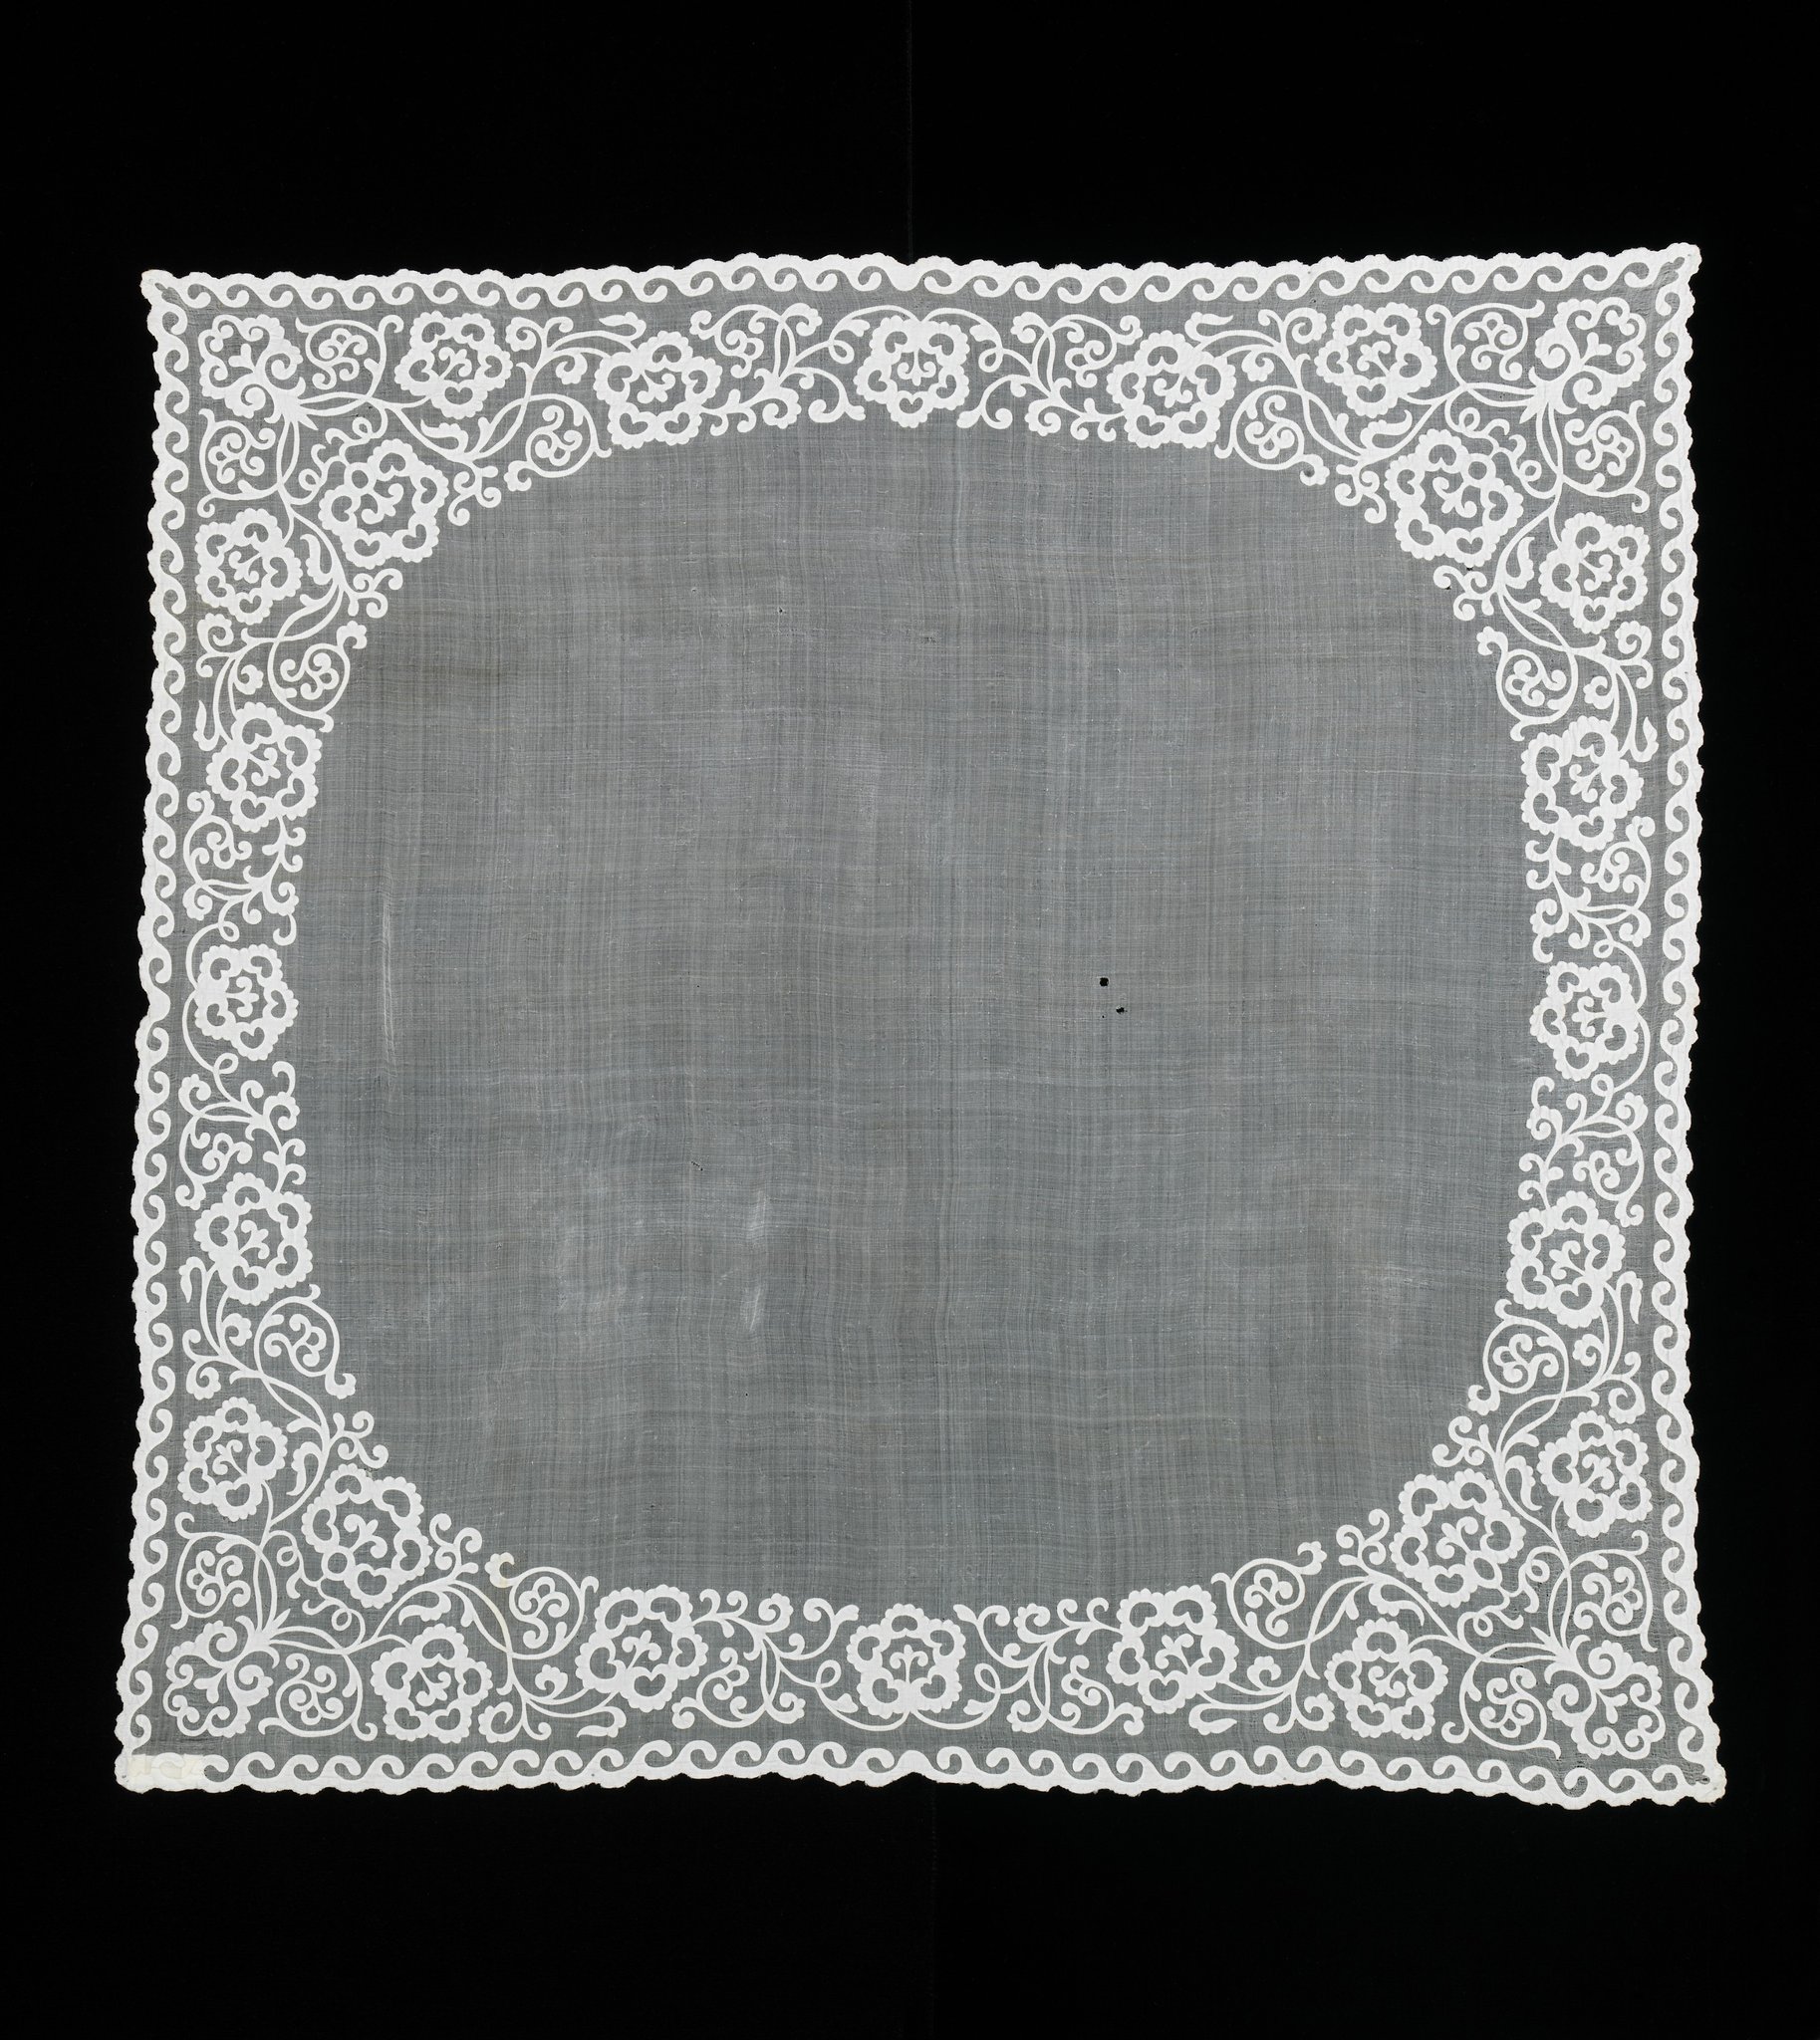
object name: headcloth kerchief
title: Kerchief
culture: philippine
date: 1851-1875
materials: cotton